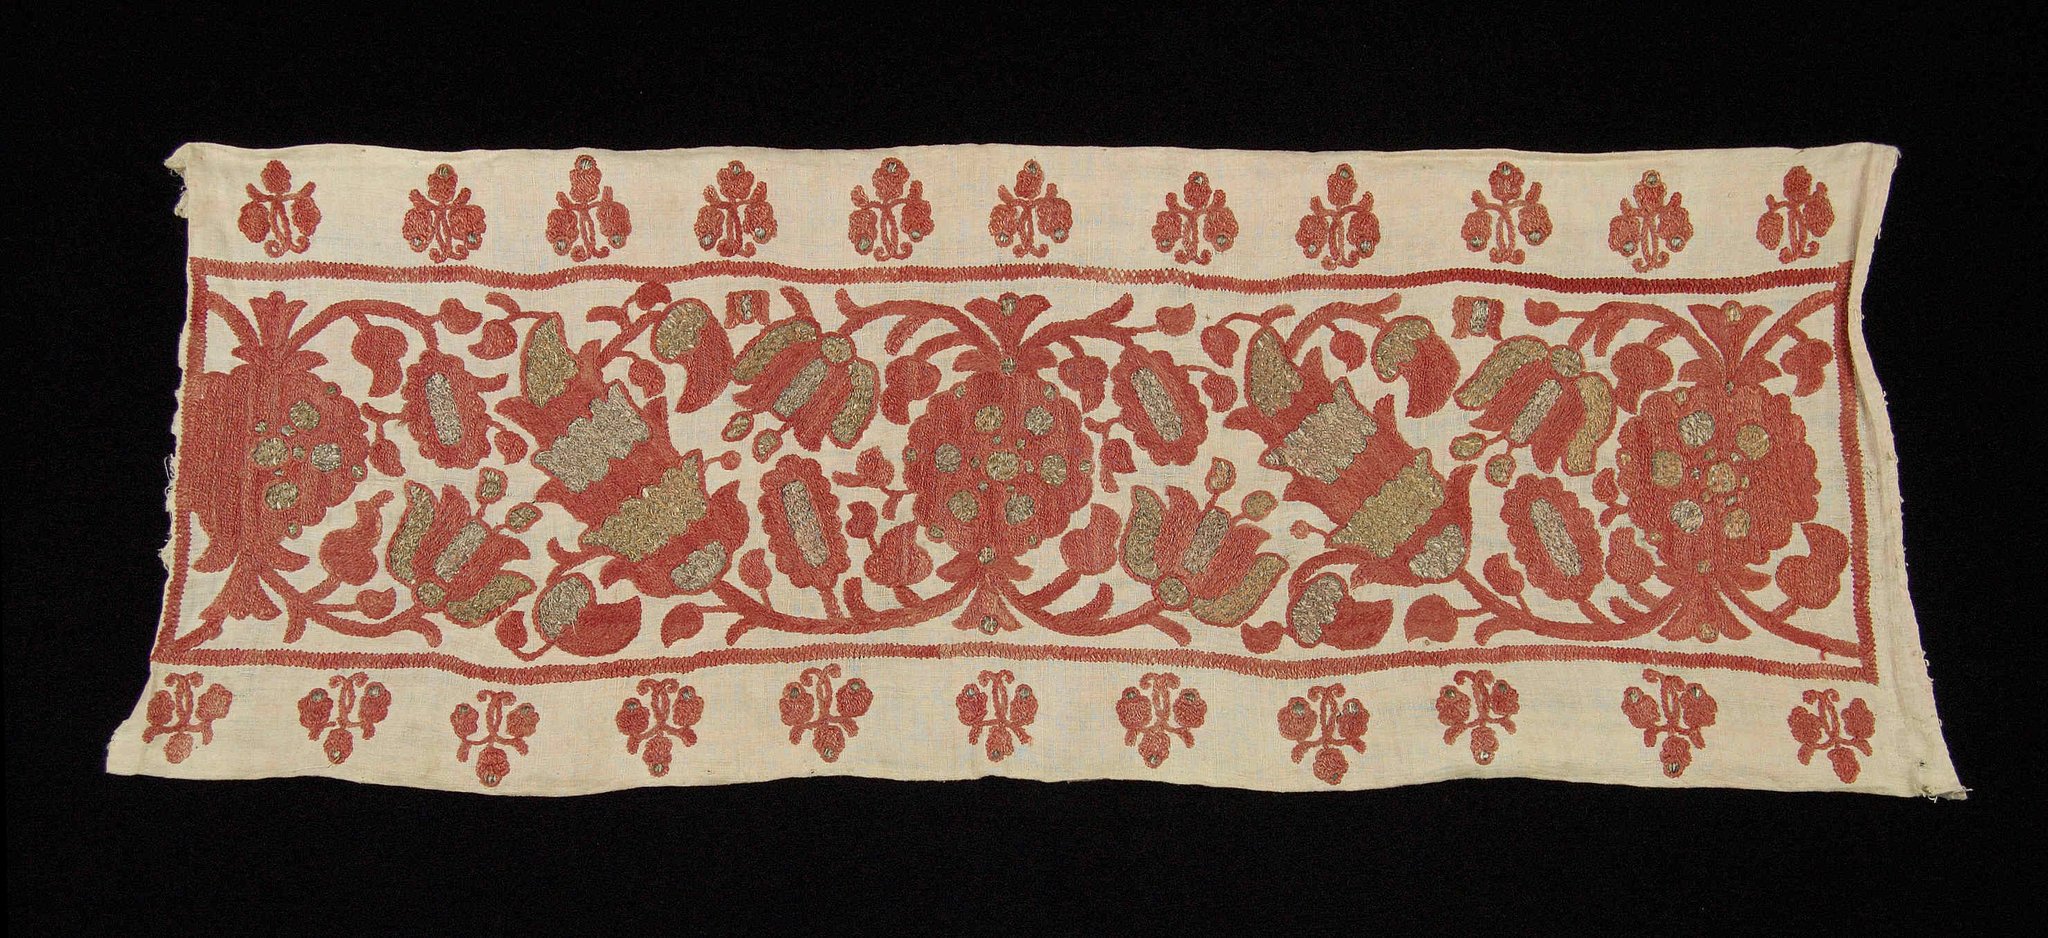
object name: textile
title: Fragment of a shirt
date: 1776-1800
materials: linen, silk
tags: flowers